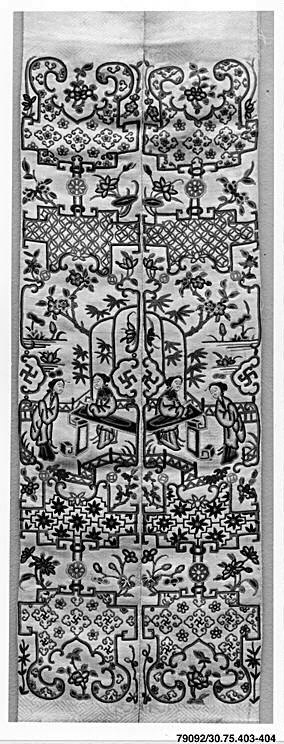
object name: sleeve band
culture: chinese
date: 1801-1900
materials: metal thread, silk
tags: women